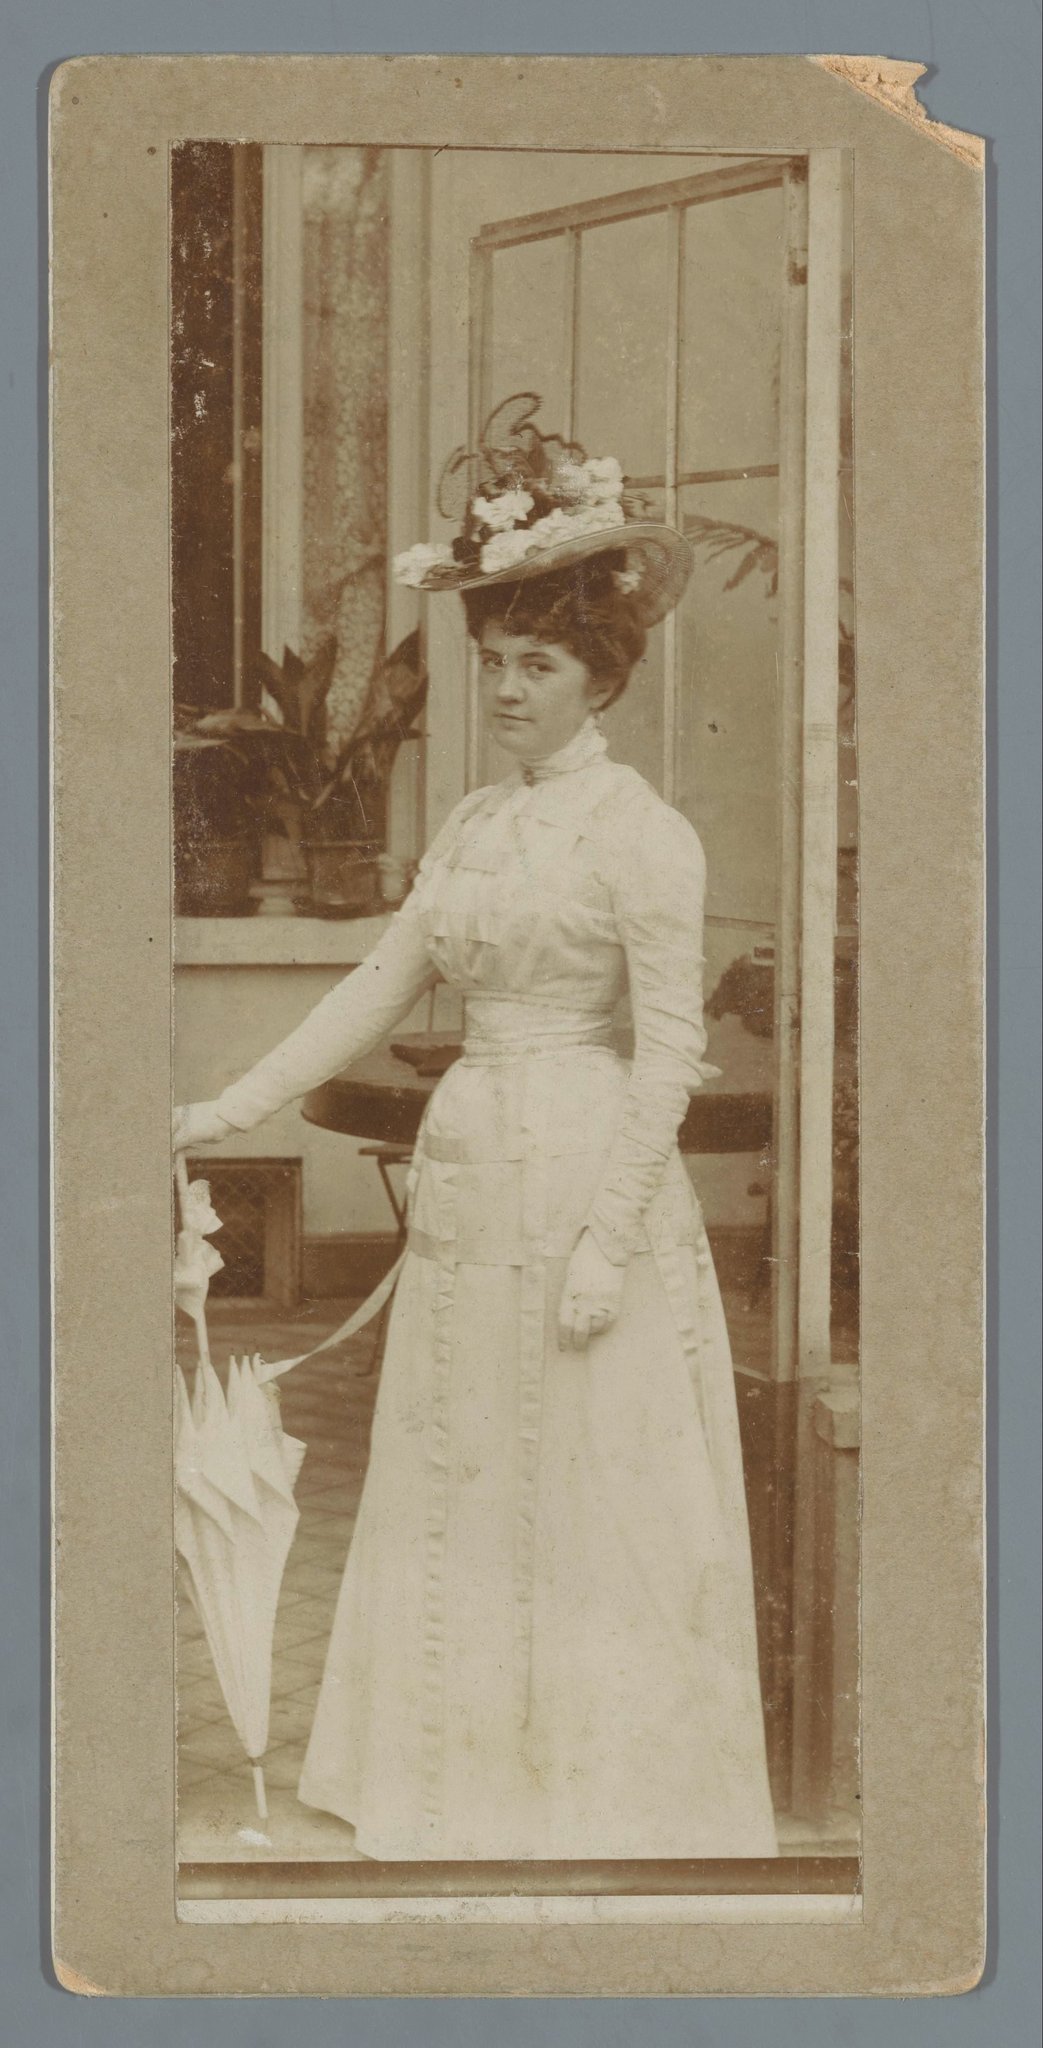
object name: photograph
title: Portret van een onbekende vrouw met een paraplu in een serre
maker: Anonymous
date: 1905-1910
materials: cardboard, photographic support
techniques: daylight paper print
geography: netherlands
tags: adult woman, umbrella, hot-house, glass-house